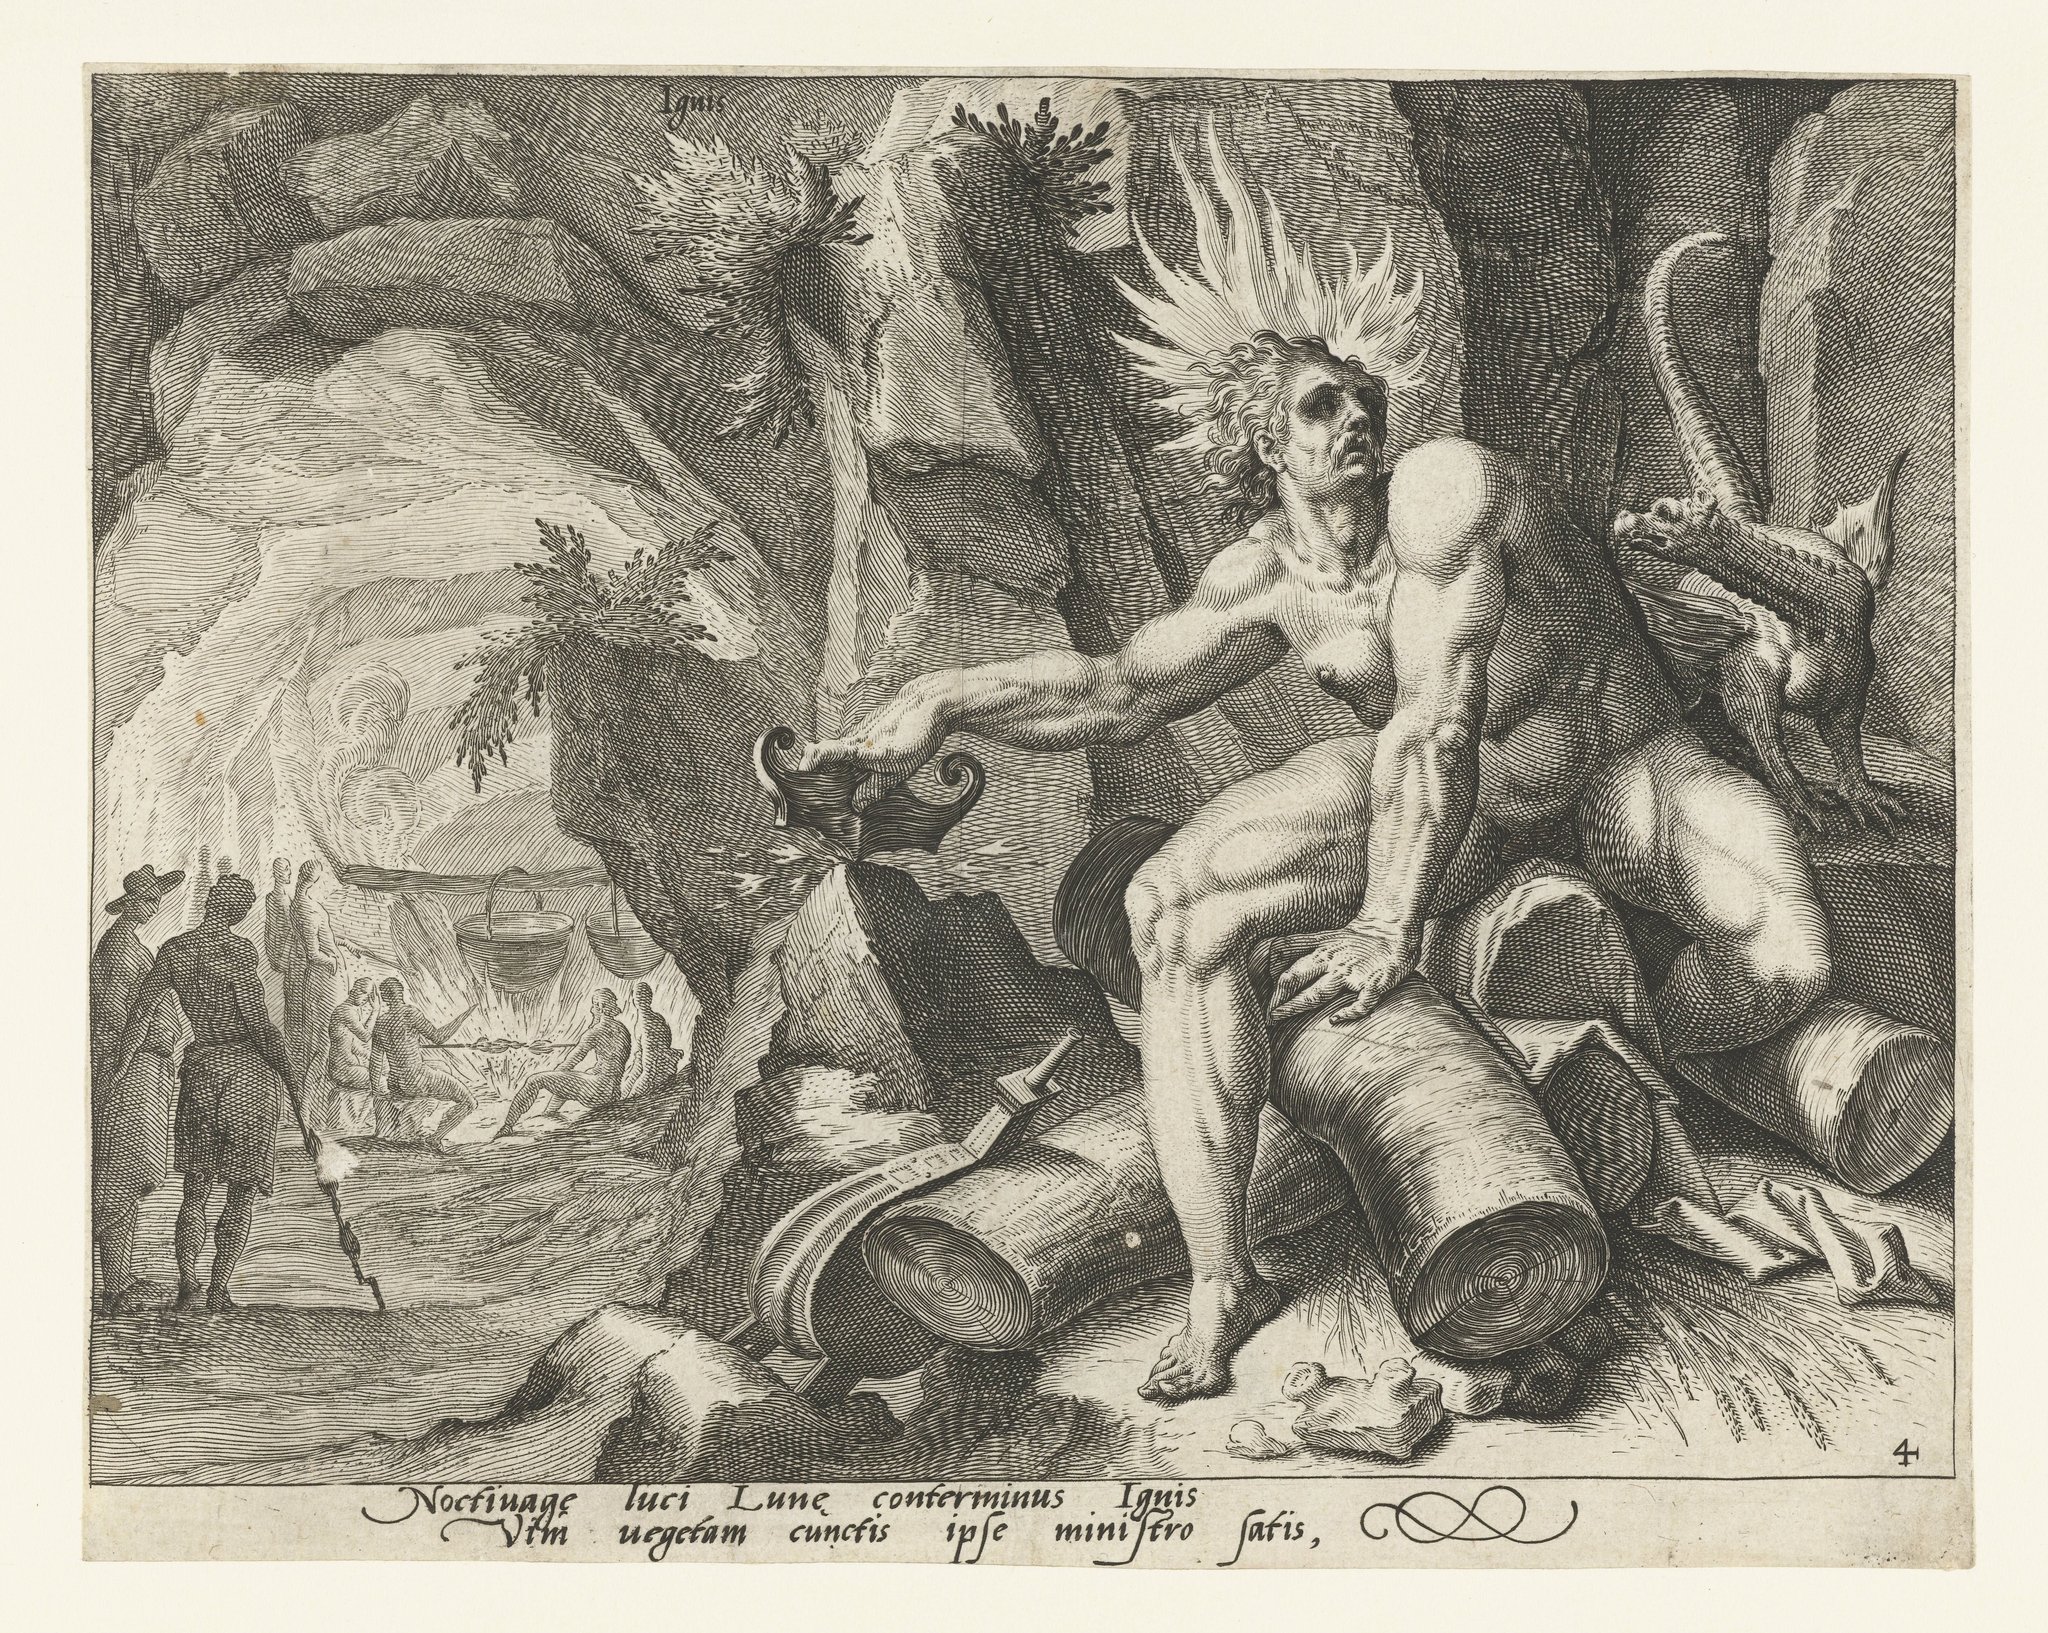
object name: print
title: De vier elementen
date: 1588-1592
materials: paper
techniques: engraving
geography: netherlands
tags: fire (one of the four elements)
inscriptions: collector's mark: Lugt 2228a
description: Voorstelling van het element vuur in de vorm van een naakte man met vlammend haar die met een vuursteen op een rots slaat. Op de achtergrond een groep mensen rond een vuur waarboven een ketel hangt. Bovenin de voorstelling het woord 'Ignis' (vuur). Onder de voorstelling twee regels tekst in Latijn. Deze prent is onderdeel van een serie van de vier elementen, elk verbeeld door een personificatie, achter wie figuren handelingen uitvoeren die geassocieerd worden met het betreffende element. Elke voorstelling heeft een tweeregelig Latijns onderschrift.